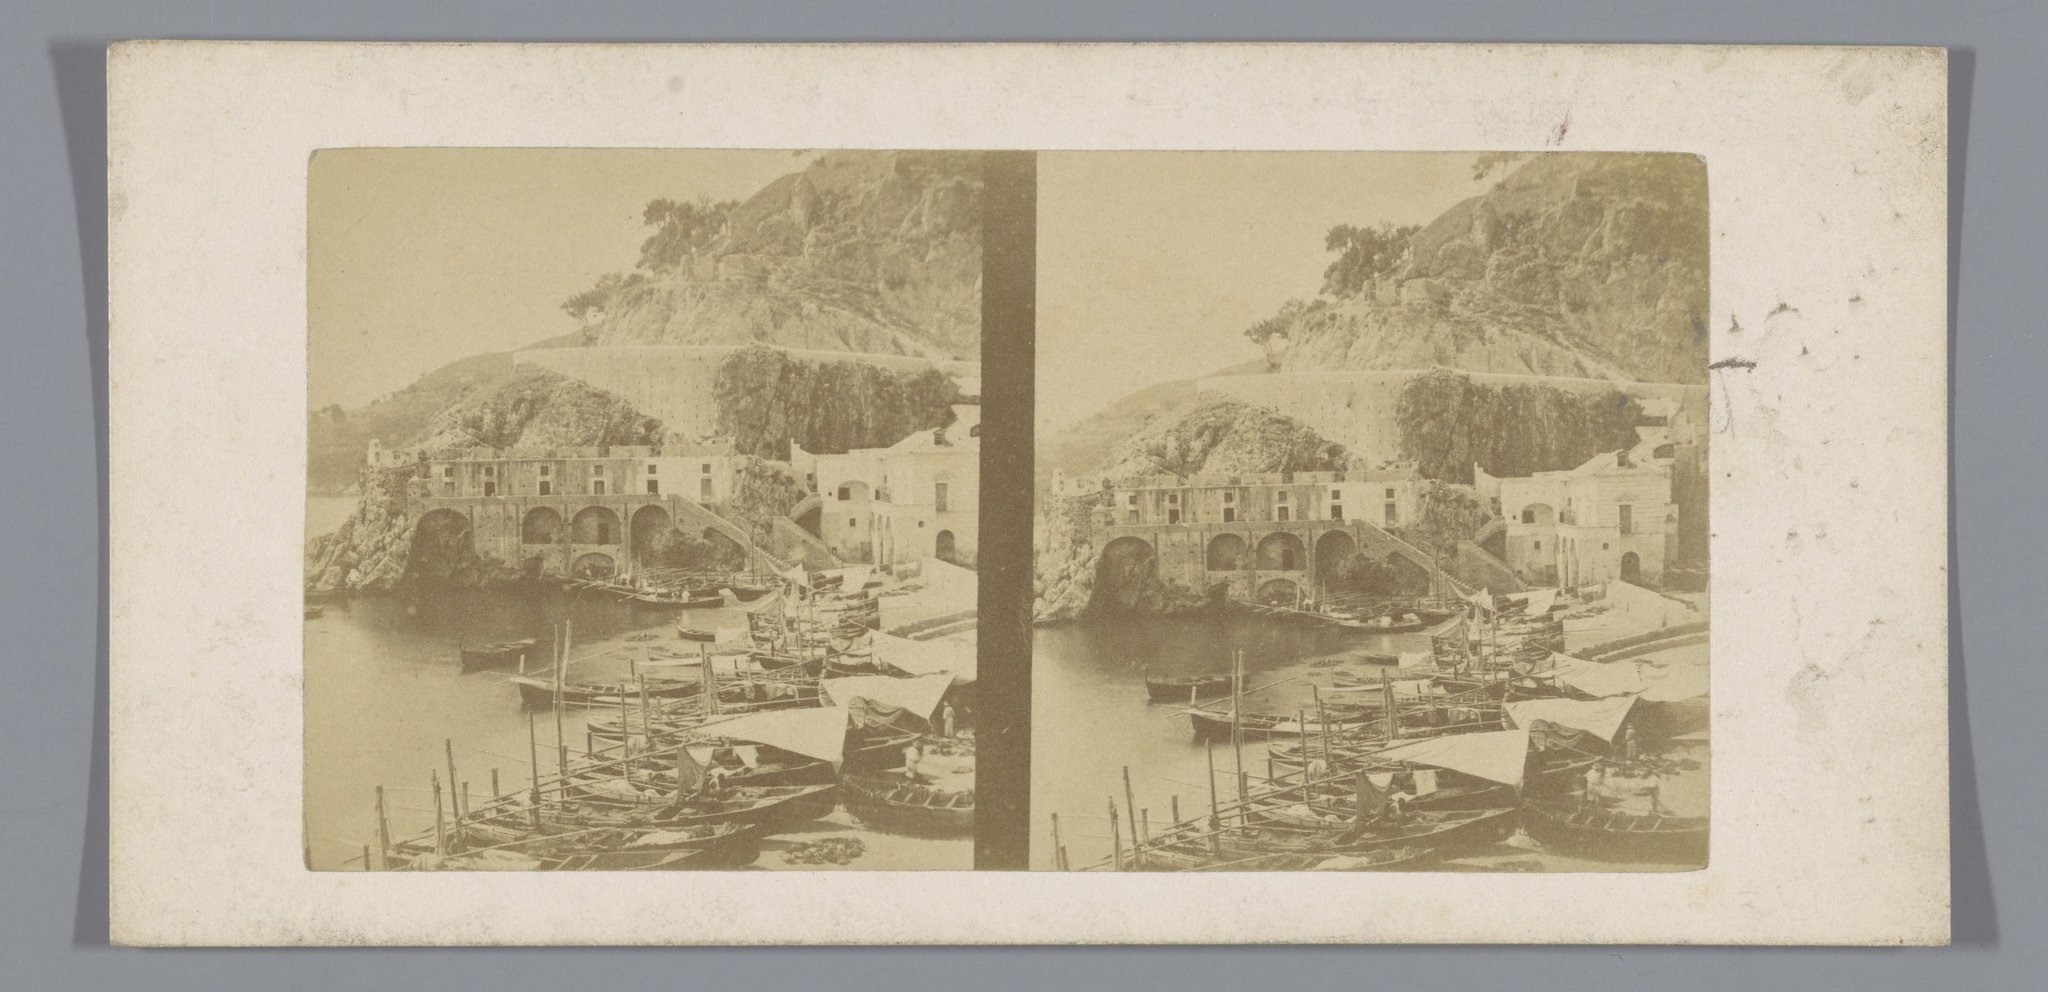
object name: stereograph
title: Cetara route d'amalfi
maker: Anonymous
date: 1857-1863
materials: cardboard, paper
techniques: albumen print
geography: cetara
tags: coast, beach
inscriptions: number: ‘6’, number: ‘6’